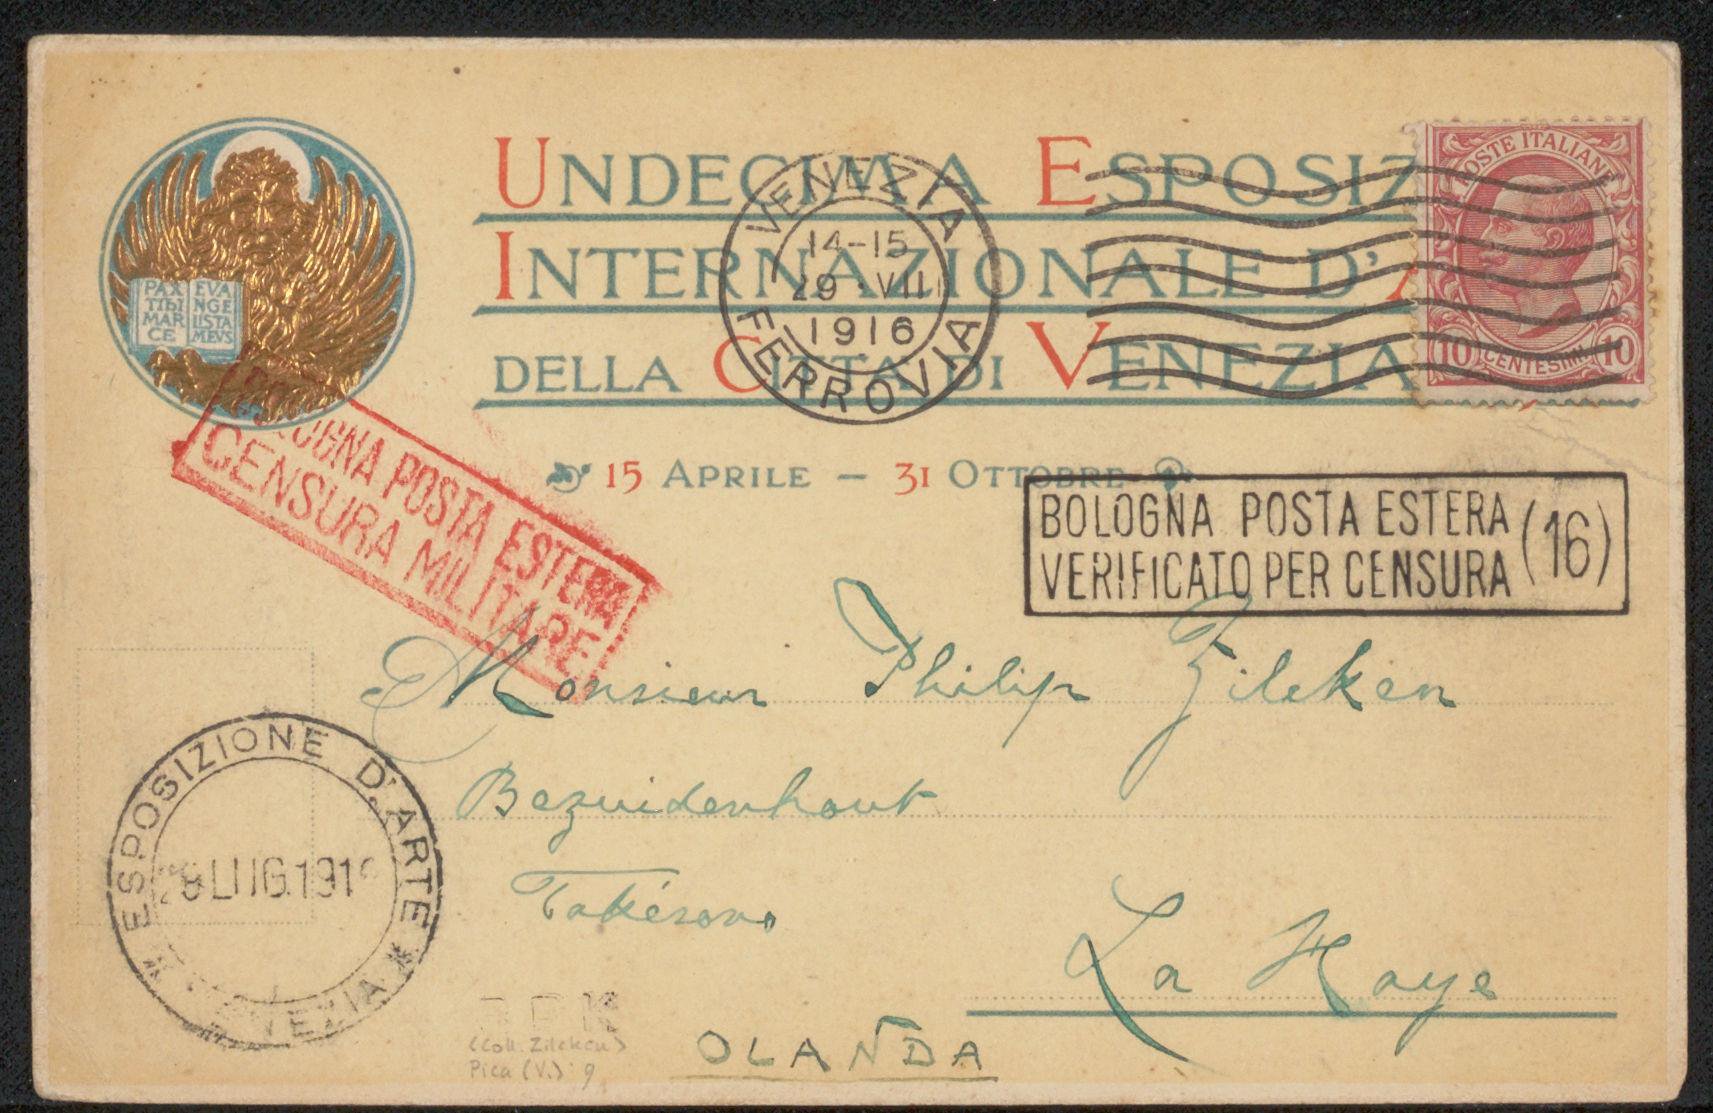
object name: postcard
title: Briefkaart aan Philip Zilcken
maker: vittorio pica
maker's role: criticus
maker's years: 1864-1930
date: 1916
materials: cardboard, ink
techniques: pen, writing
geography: venice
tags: painter, draughtsman, philip zilcken, the graphic arts, printed matter, the hague, paris, venice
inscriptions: collector's mark: ‘RPK’